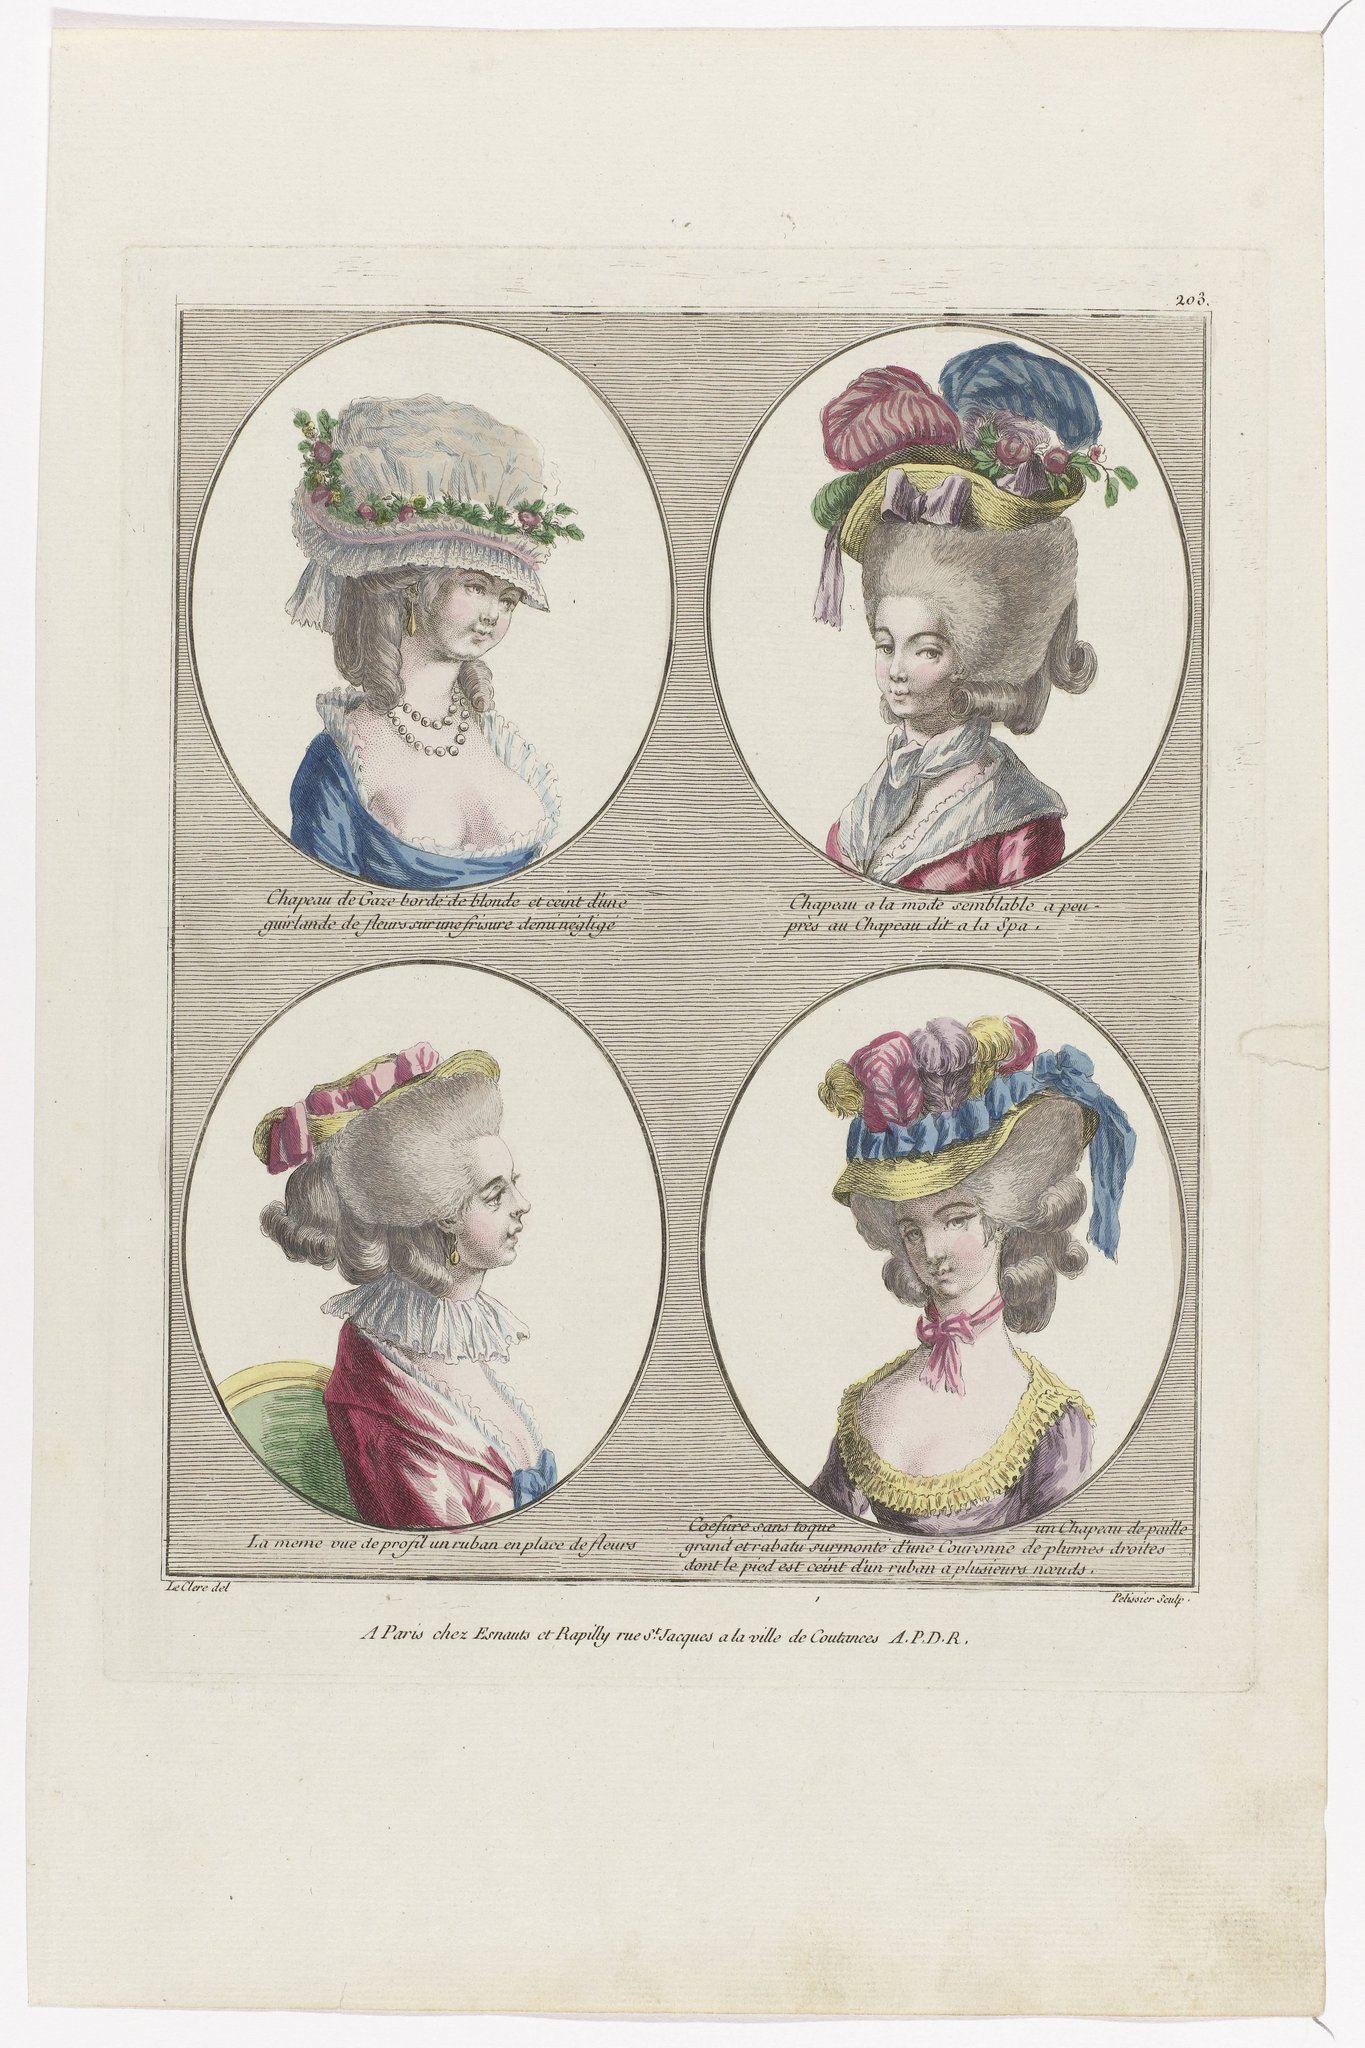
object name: fashion print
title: Gallerie des Modes et Costumes Français, 1780, 203 : Chapeau de Gaz (...)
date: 1780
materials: paper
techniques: engraving, hand coloring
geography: paris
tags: flowers, ear-rings (+ women's clothes), border, ribbon, braid (+ women's clothes), lace (+ women's clothes), head-gear (straw hat) (+ women's clothes), styles of hairdress - aa - ~ women, fashion plates, necklace (+ women's clothes)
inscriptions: address: ‘A Paris chez Esnauts et Rapilly rue St. Jacques a la ville de Coutances. A.P.D.R.’, inscription: ‘Chapeau de Gaze bordé de blonde et ceint d'une guirlande de fleurs sur une frisure demi négligé’, inscription: ‘Coefure sans toque un Chapeau de paille grand et rabatu surmonté d'une Couronne de plumes droites dont le pied est ceint d'un ruban a plusieurs noeuds.’, inscription: ‘Chapeau a la mode semblable a peu-près Chapeau dit a la Spa.’, inscription: ‘La meme vue de profil un ruban en place de fleurs’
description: Vier dameskapsels met verschillende hoofddeksels, verdeeld in ovalen. Linksboven: hoed van gaas afgezet met blonde (kloskant) en bloemenguirlande, gedragen op een kapsel 'demi négligé'. Rechtsboven: hoed volgens de laatste mode vergelijkbaar met de hoed genaamd 'a la Spa'. Linksonder: hoed versierd met lint in plaats van bloemen. Rechtsonder: 'coeffure' zonder 'toque' en een grote strohoed met bovenop pluimen en rondom een lint met strikken. Prent uit de serie 34e Cahier de Costumes Français, 8e Suite de Coeffures à la mode en 1780, Gallerie des Modes et Costumes Français.